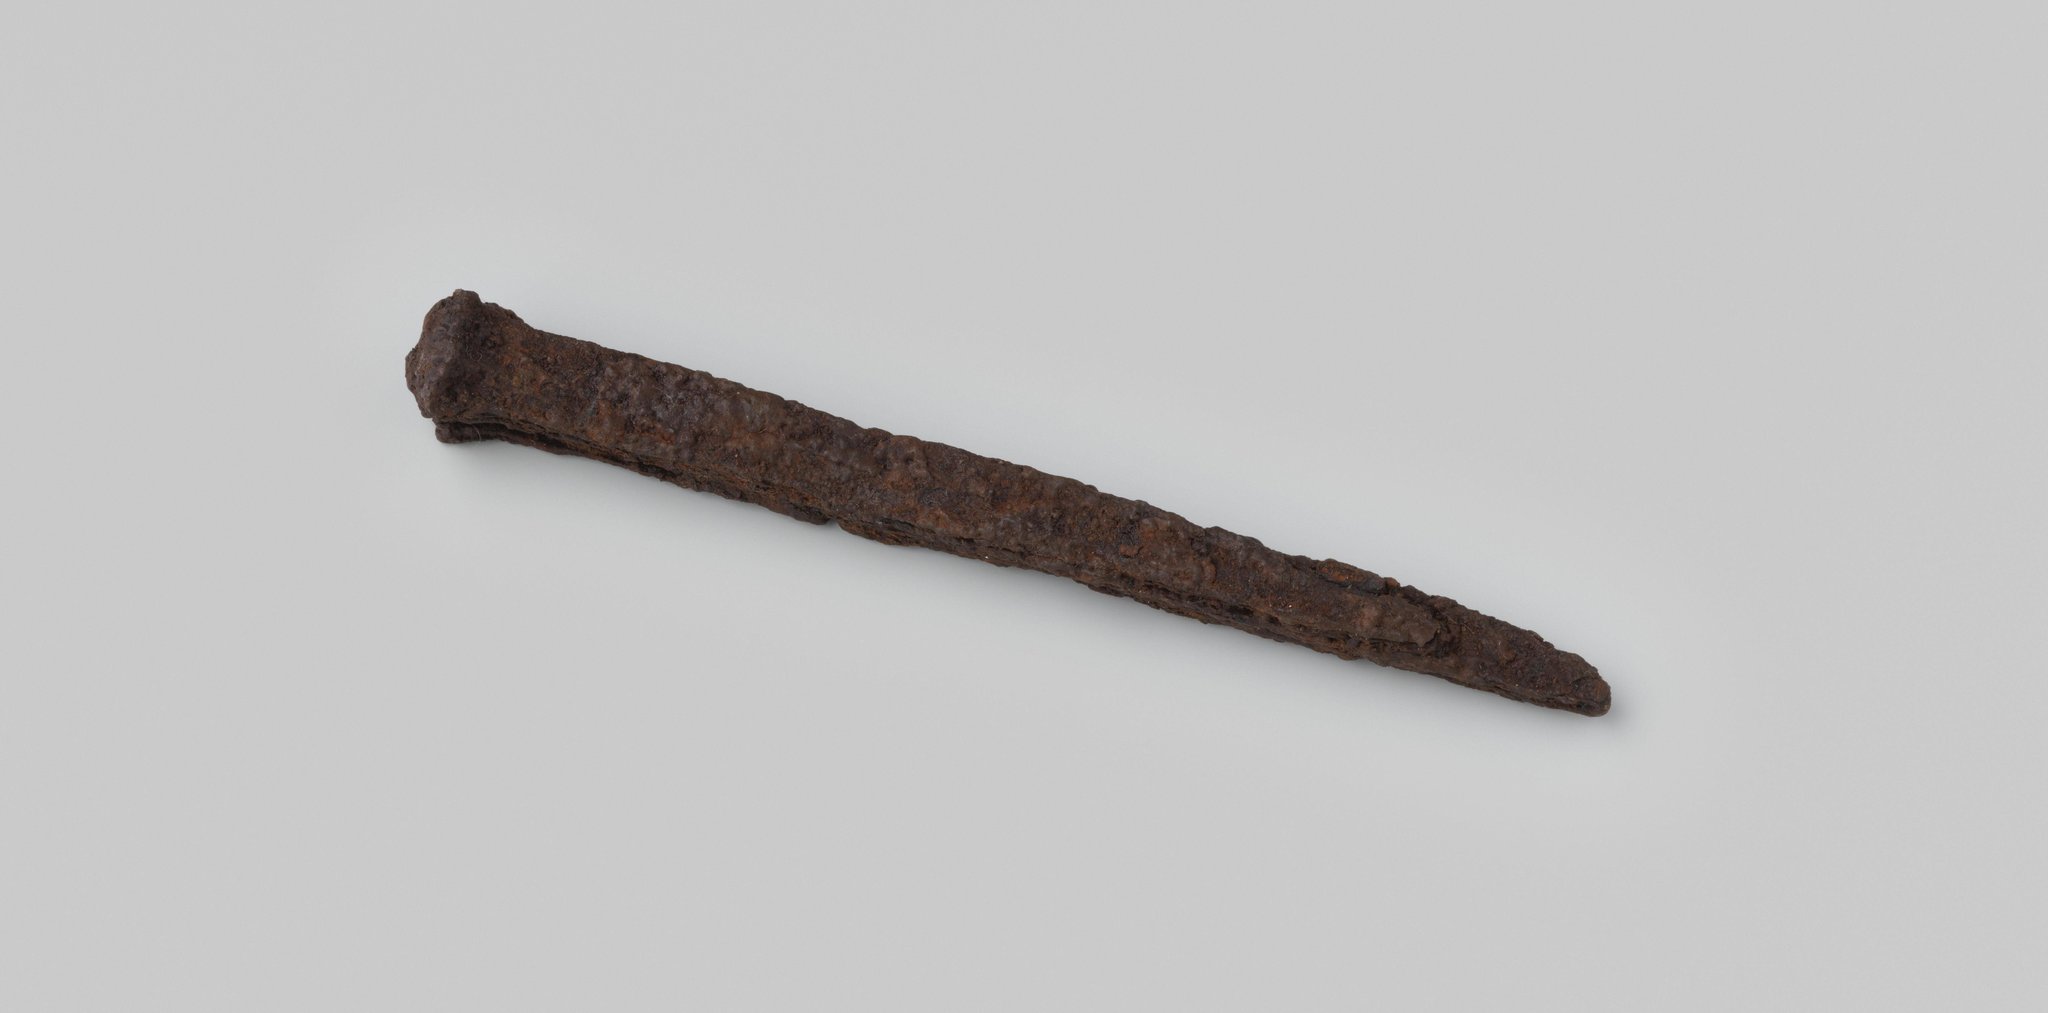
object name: nagel, spijker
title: Spijker afkomstig uit het wrak van de Oost-Indiëvaarder Hollandia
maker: Anonymous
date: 1700-1743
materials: iron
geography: netherlands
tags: verenigde oostindische compagnie, hollandia (schip)